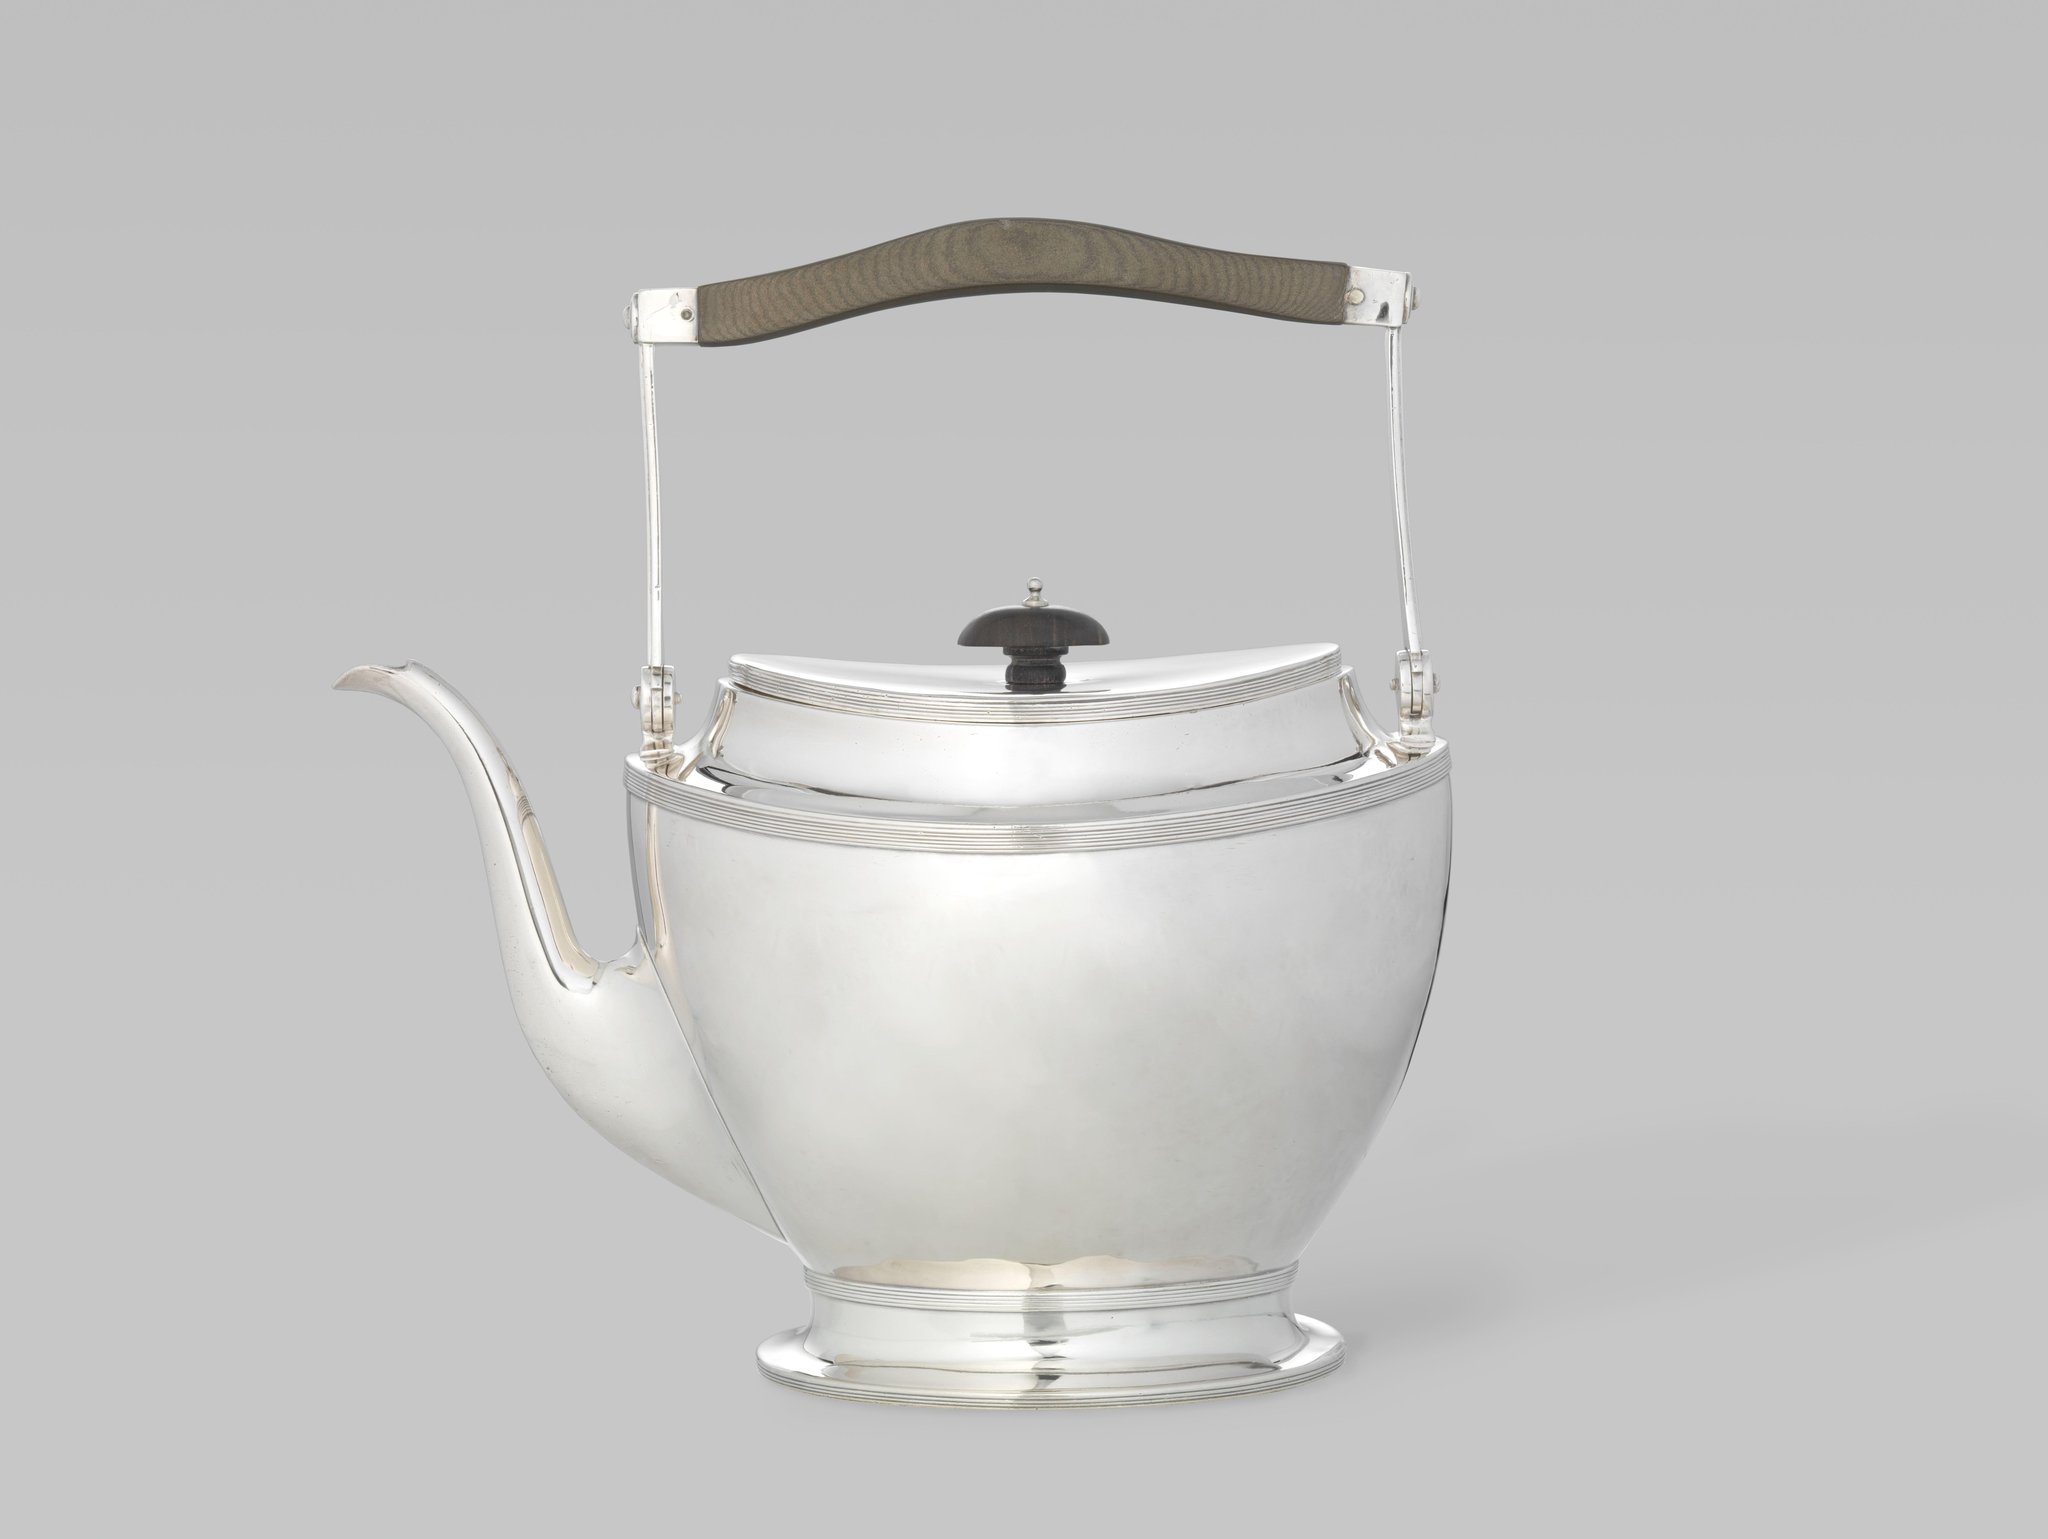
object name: teakettle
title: Bouiloire, ovaal, met filetranden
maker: jacobus carrenhoff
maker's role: silversmith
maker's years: 1771-1848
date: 1817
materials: wood, silver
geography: amsterdam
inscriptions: retailer's mark: ‘DIEMONT’, alloy mark, maker's mark, date letter: ‘H’, assay office mark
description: Kettle. Silver, ebony handle and knob of lid. Amsterdam, 1817, by Jacobus Carrenhof. Trademark of Willem Diemont. Given by Mr and Mrs Jaffé-Pierson, 1978.